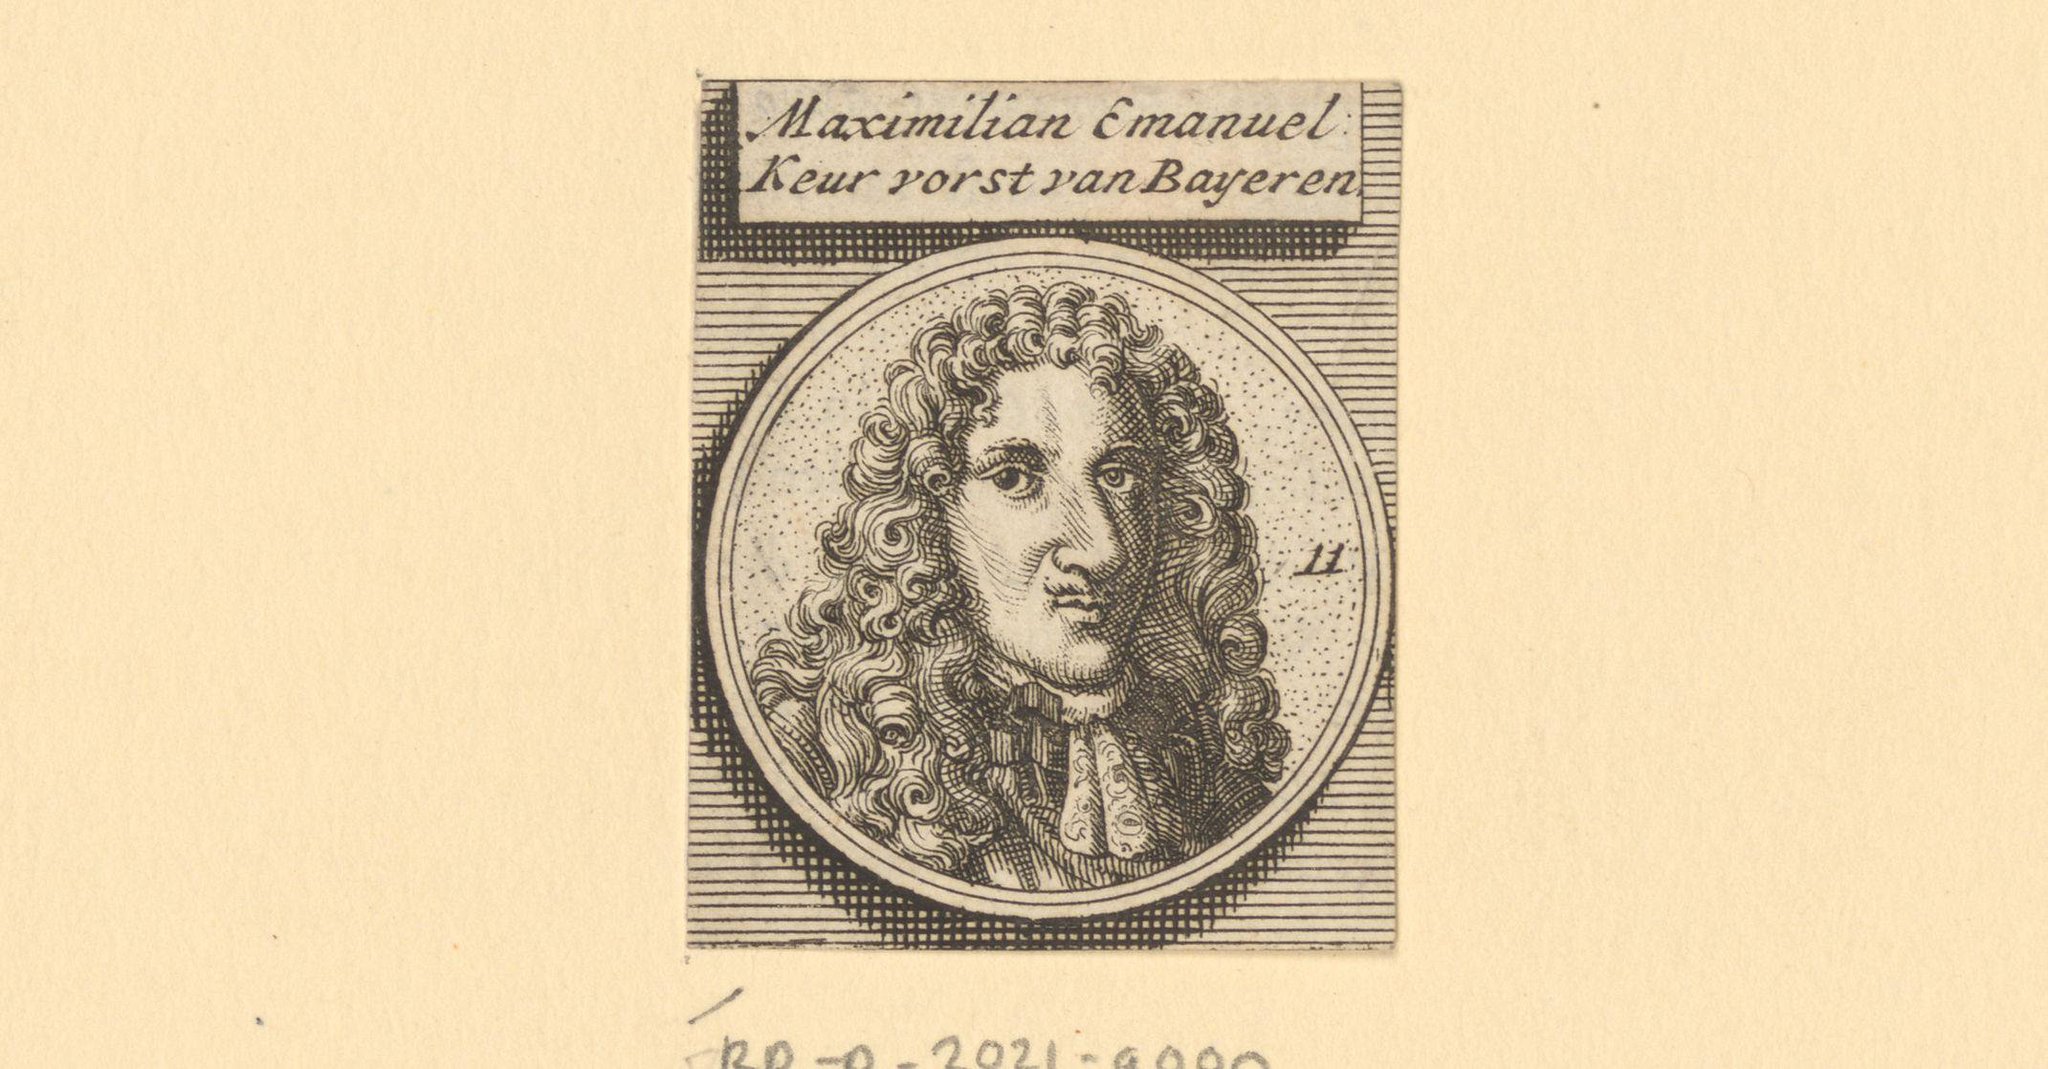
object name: book illustration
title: Portret van Maximiliaan II Emanuel van Beieren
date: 1700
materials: paper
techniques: etching, letterpress printing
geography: northern netherlands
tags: maximiliaan ii emanuel (keurvorst van beieren), historical persons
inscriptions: inscription: ‘26 febr 1726’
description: Prent uit: Gottfried, Johann Ludwig. Historische Kronyck (...). Leiden: Pieter van der Aa, 1700, dl. 2. Portret is geknipt uit een grotere prent met verschillende portretten.